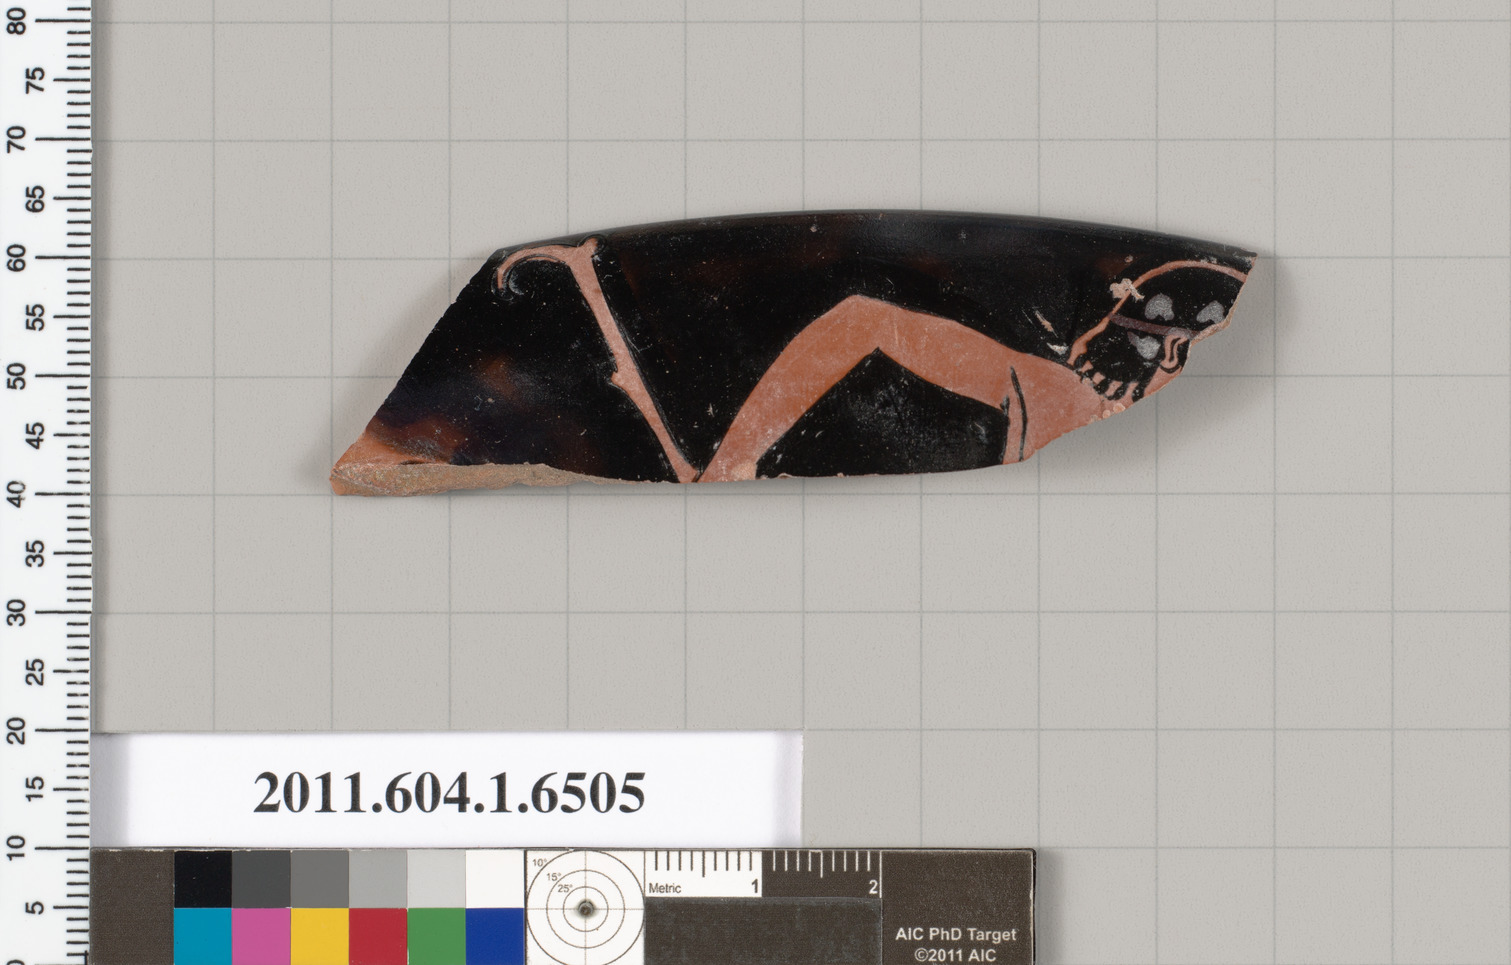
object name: kylix fragment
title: Terracotta rim fragment of a kylix (drinking cup)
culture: greek, attic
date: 490-480 BCE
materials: terracotta